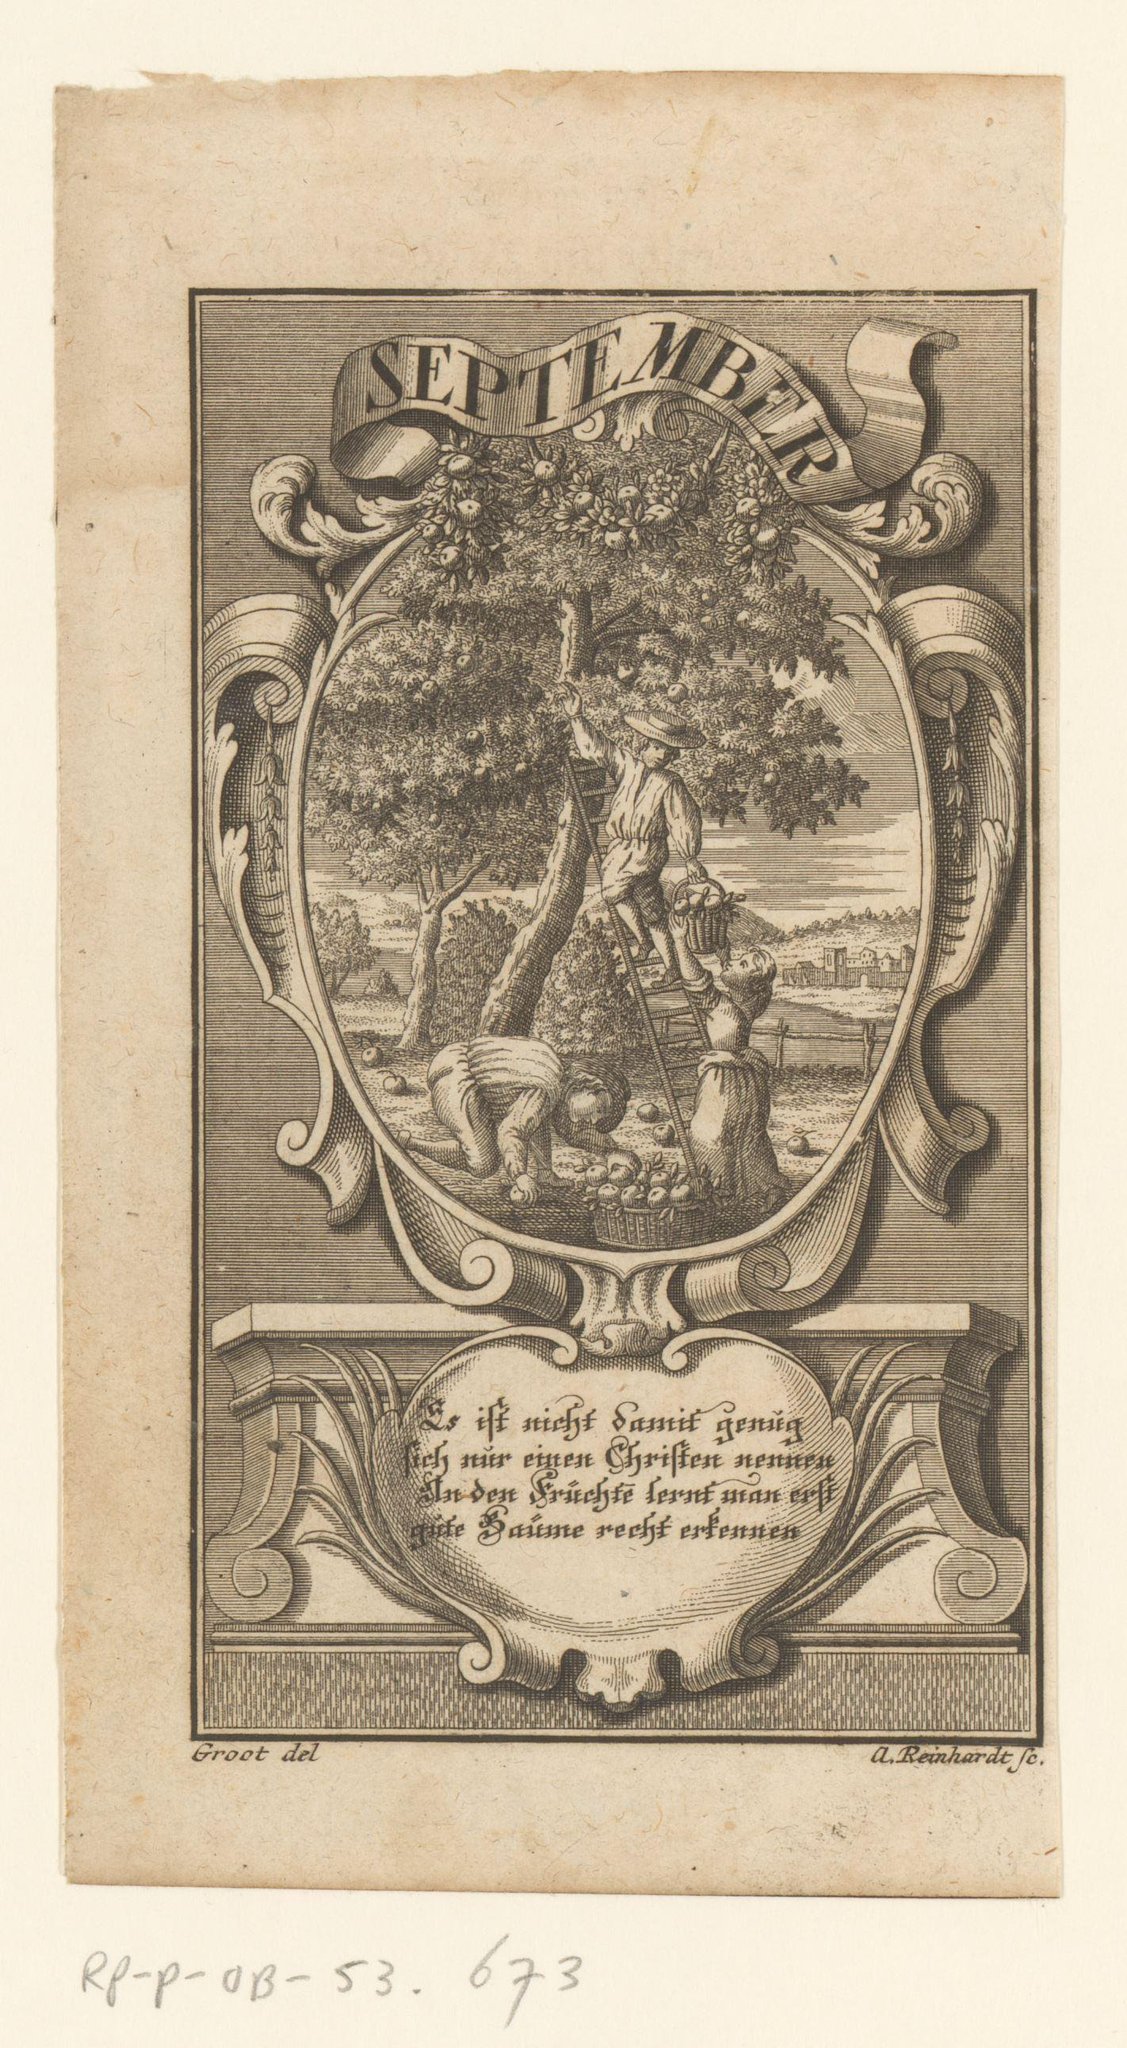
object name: print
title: Kalenderblad September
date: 1686-1752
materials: paper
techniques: etching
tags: the twelve months represented by scenes showing human activities, usually in a landscape; so-called 'labours of the months'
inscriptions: collector's mark: Lugt 2228